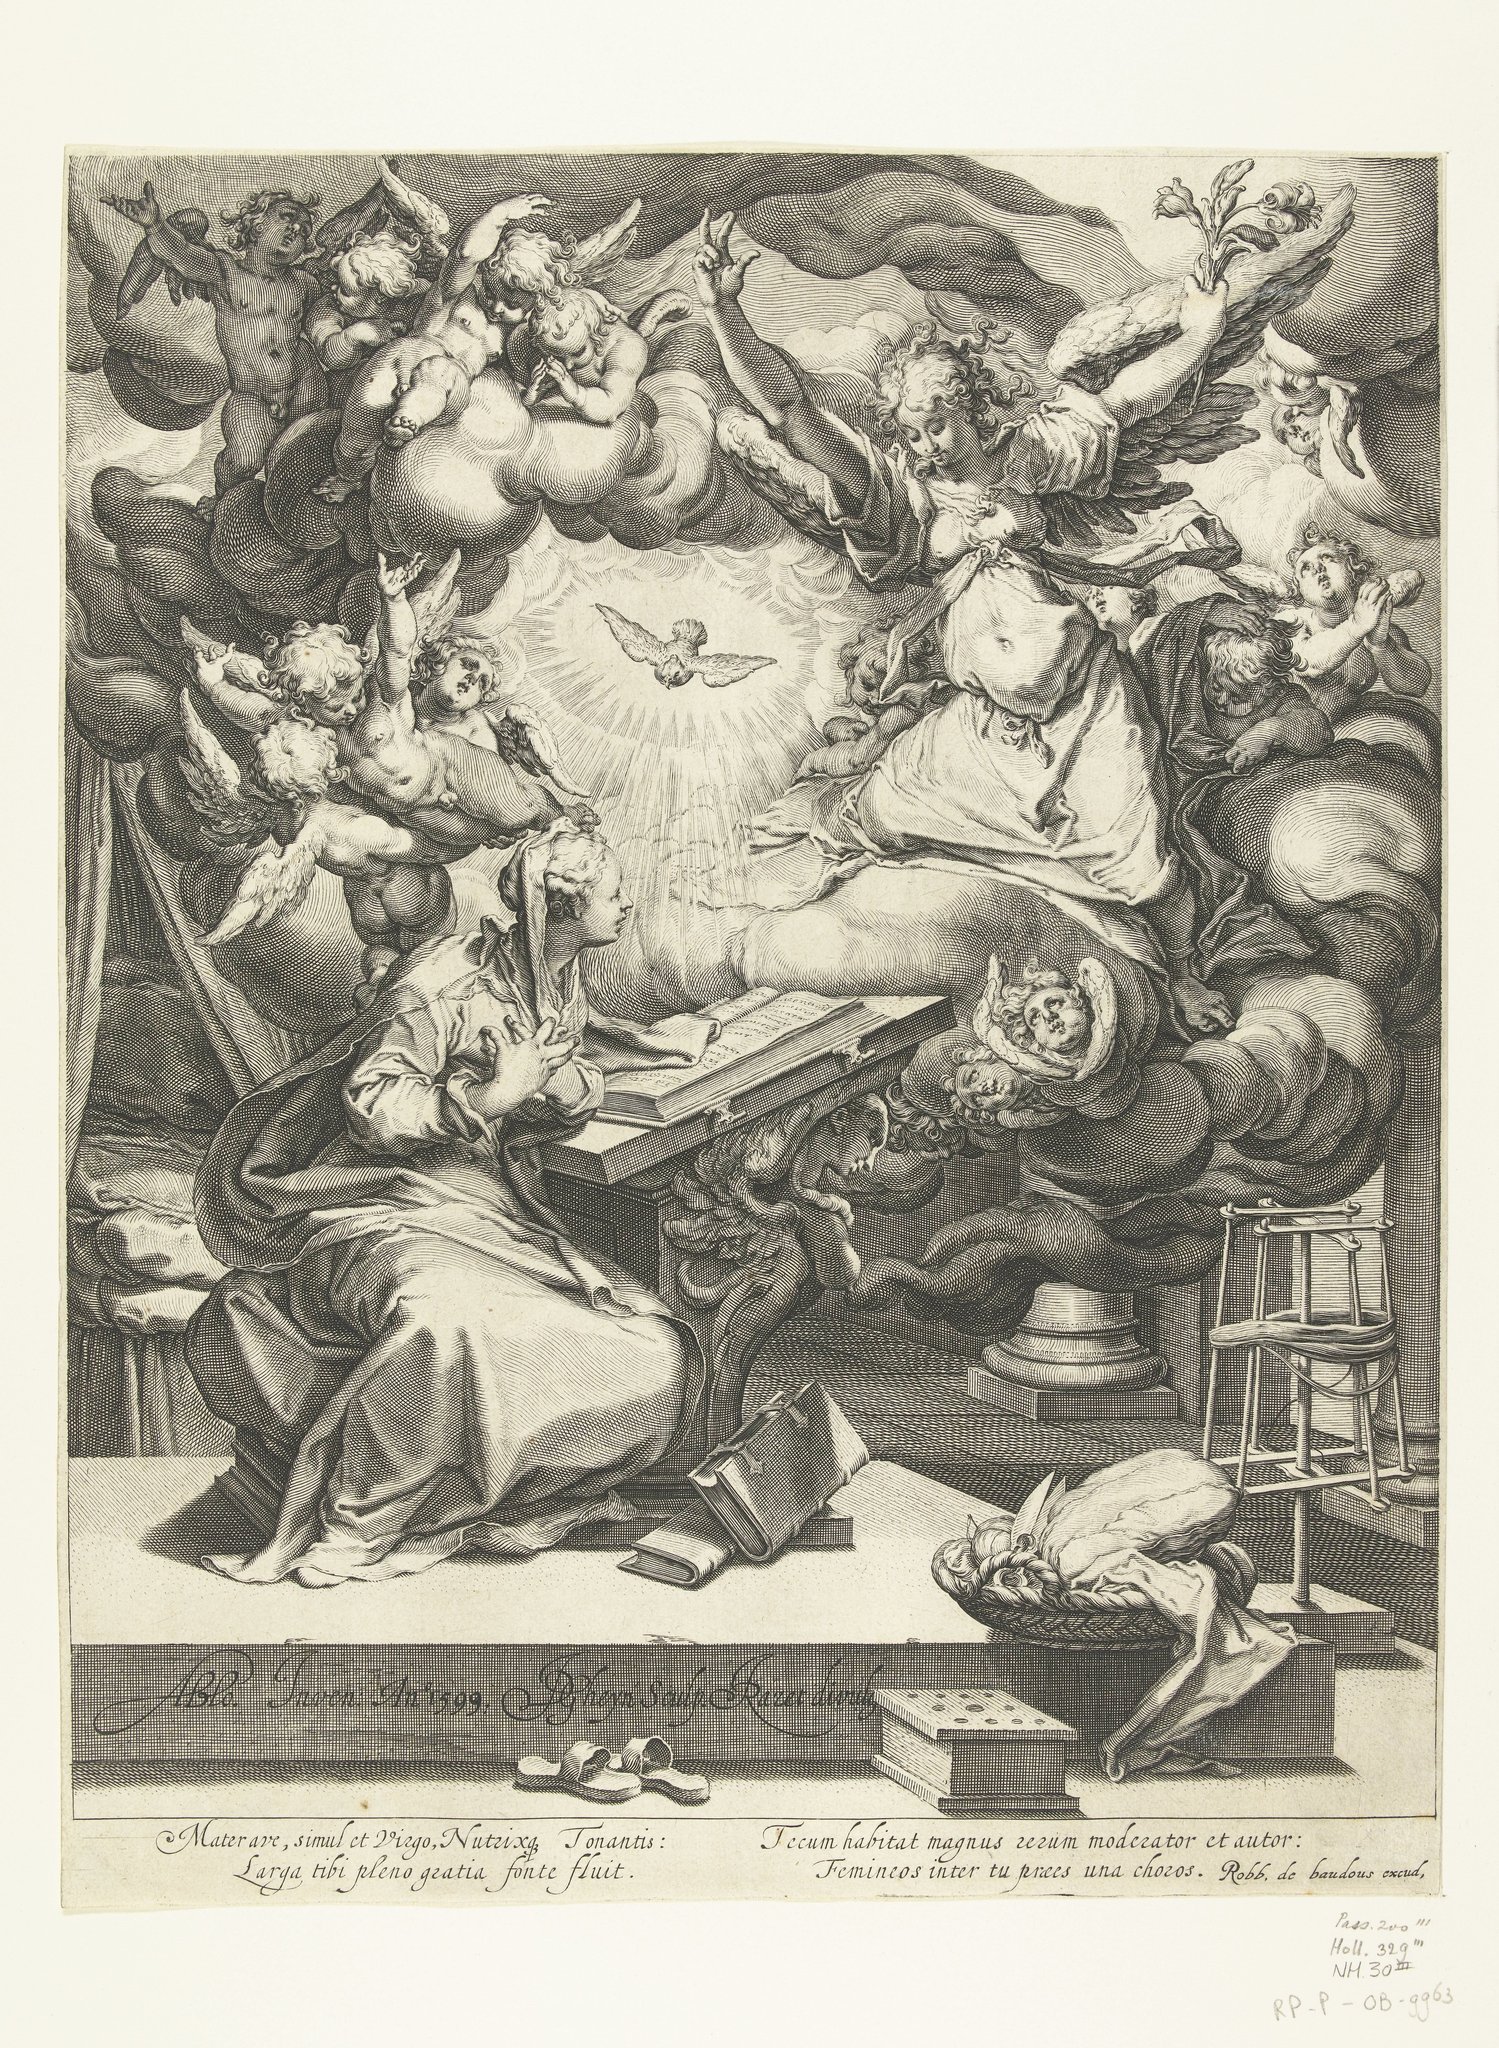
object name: print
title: Annunciatie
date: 1599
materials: paper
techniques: engraving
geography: amsterdam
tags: the annunciation: mary sitting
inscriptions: collector's mark: Lugt 240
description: De engel Gabriël verkondigt, uit de hemel komend op een wolk en begeleid door kleine engeltjes en door de Heilige Geest in de gedaante van een duif, de geboorte van Christus aan Maria, die in een slaapvertrek op een verhoging aan een lezenaar zit. Op de voorgrond slippers, een stoof en een mand naaigerei. Onder de voorstelling vier regels Latijnse tekst.